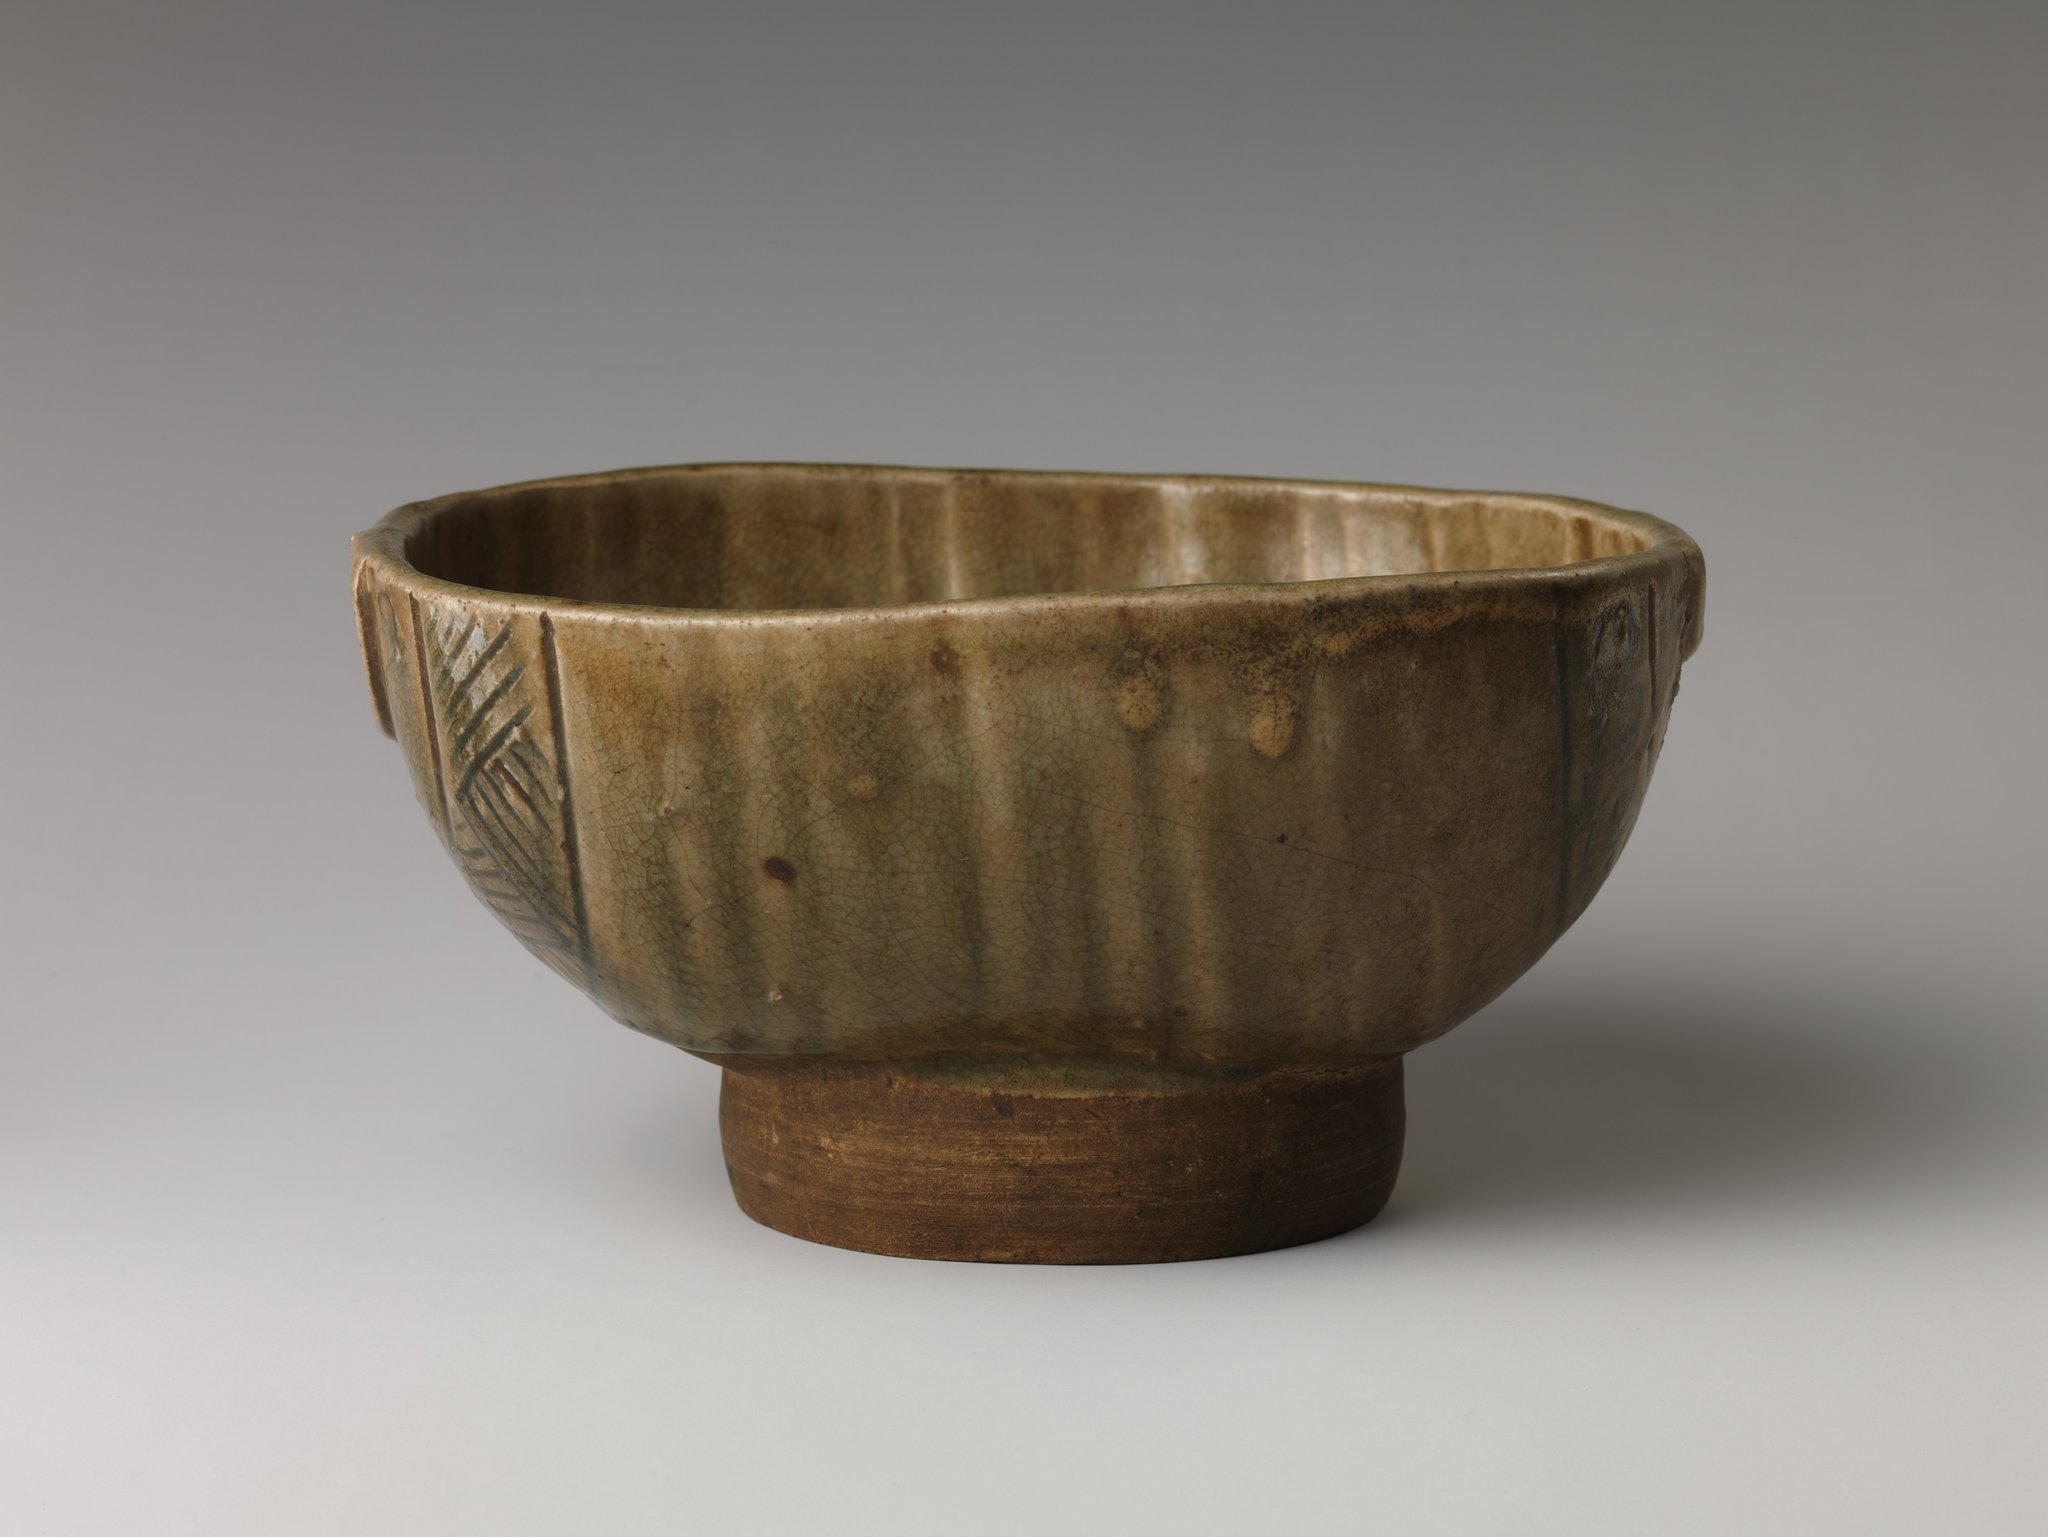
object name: bowl, deep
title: Deep Bowl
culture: japanese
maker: shuntai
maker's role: artist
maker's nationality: japanese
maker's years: 1799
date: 1801-1900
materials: clay, glaze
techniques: incising